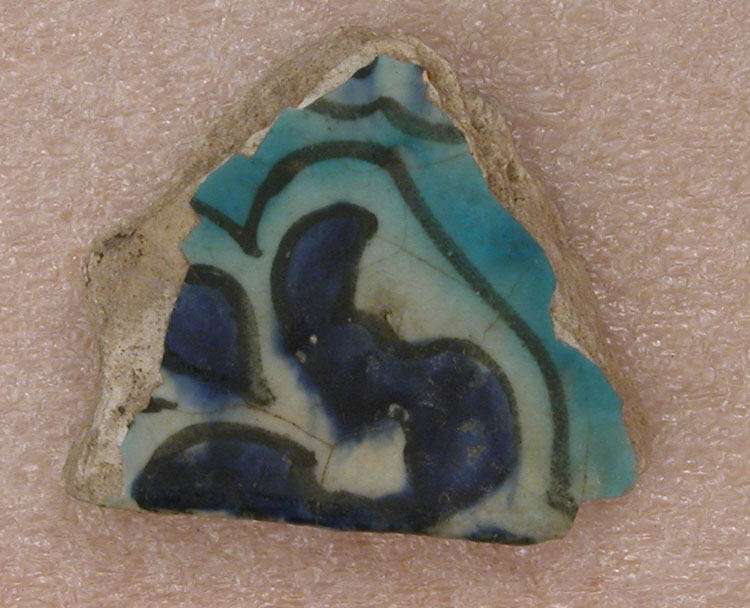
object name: tile fragment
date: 1334-1434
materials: glaze, stonepaste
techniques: painting, polychrome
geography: uzbekistan